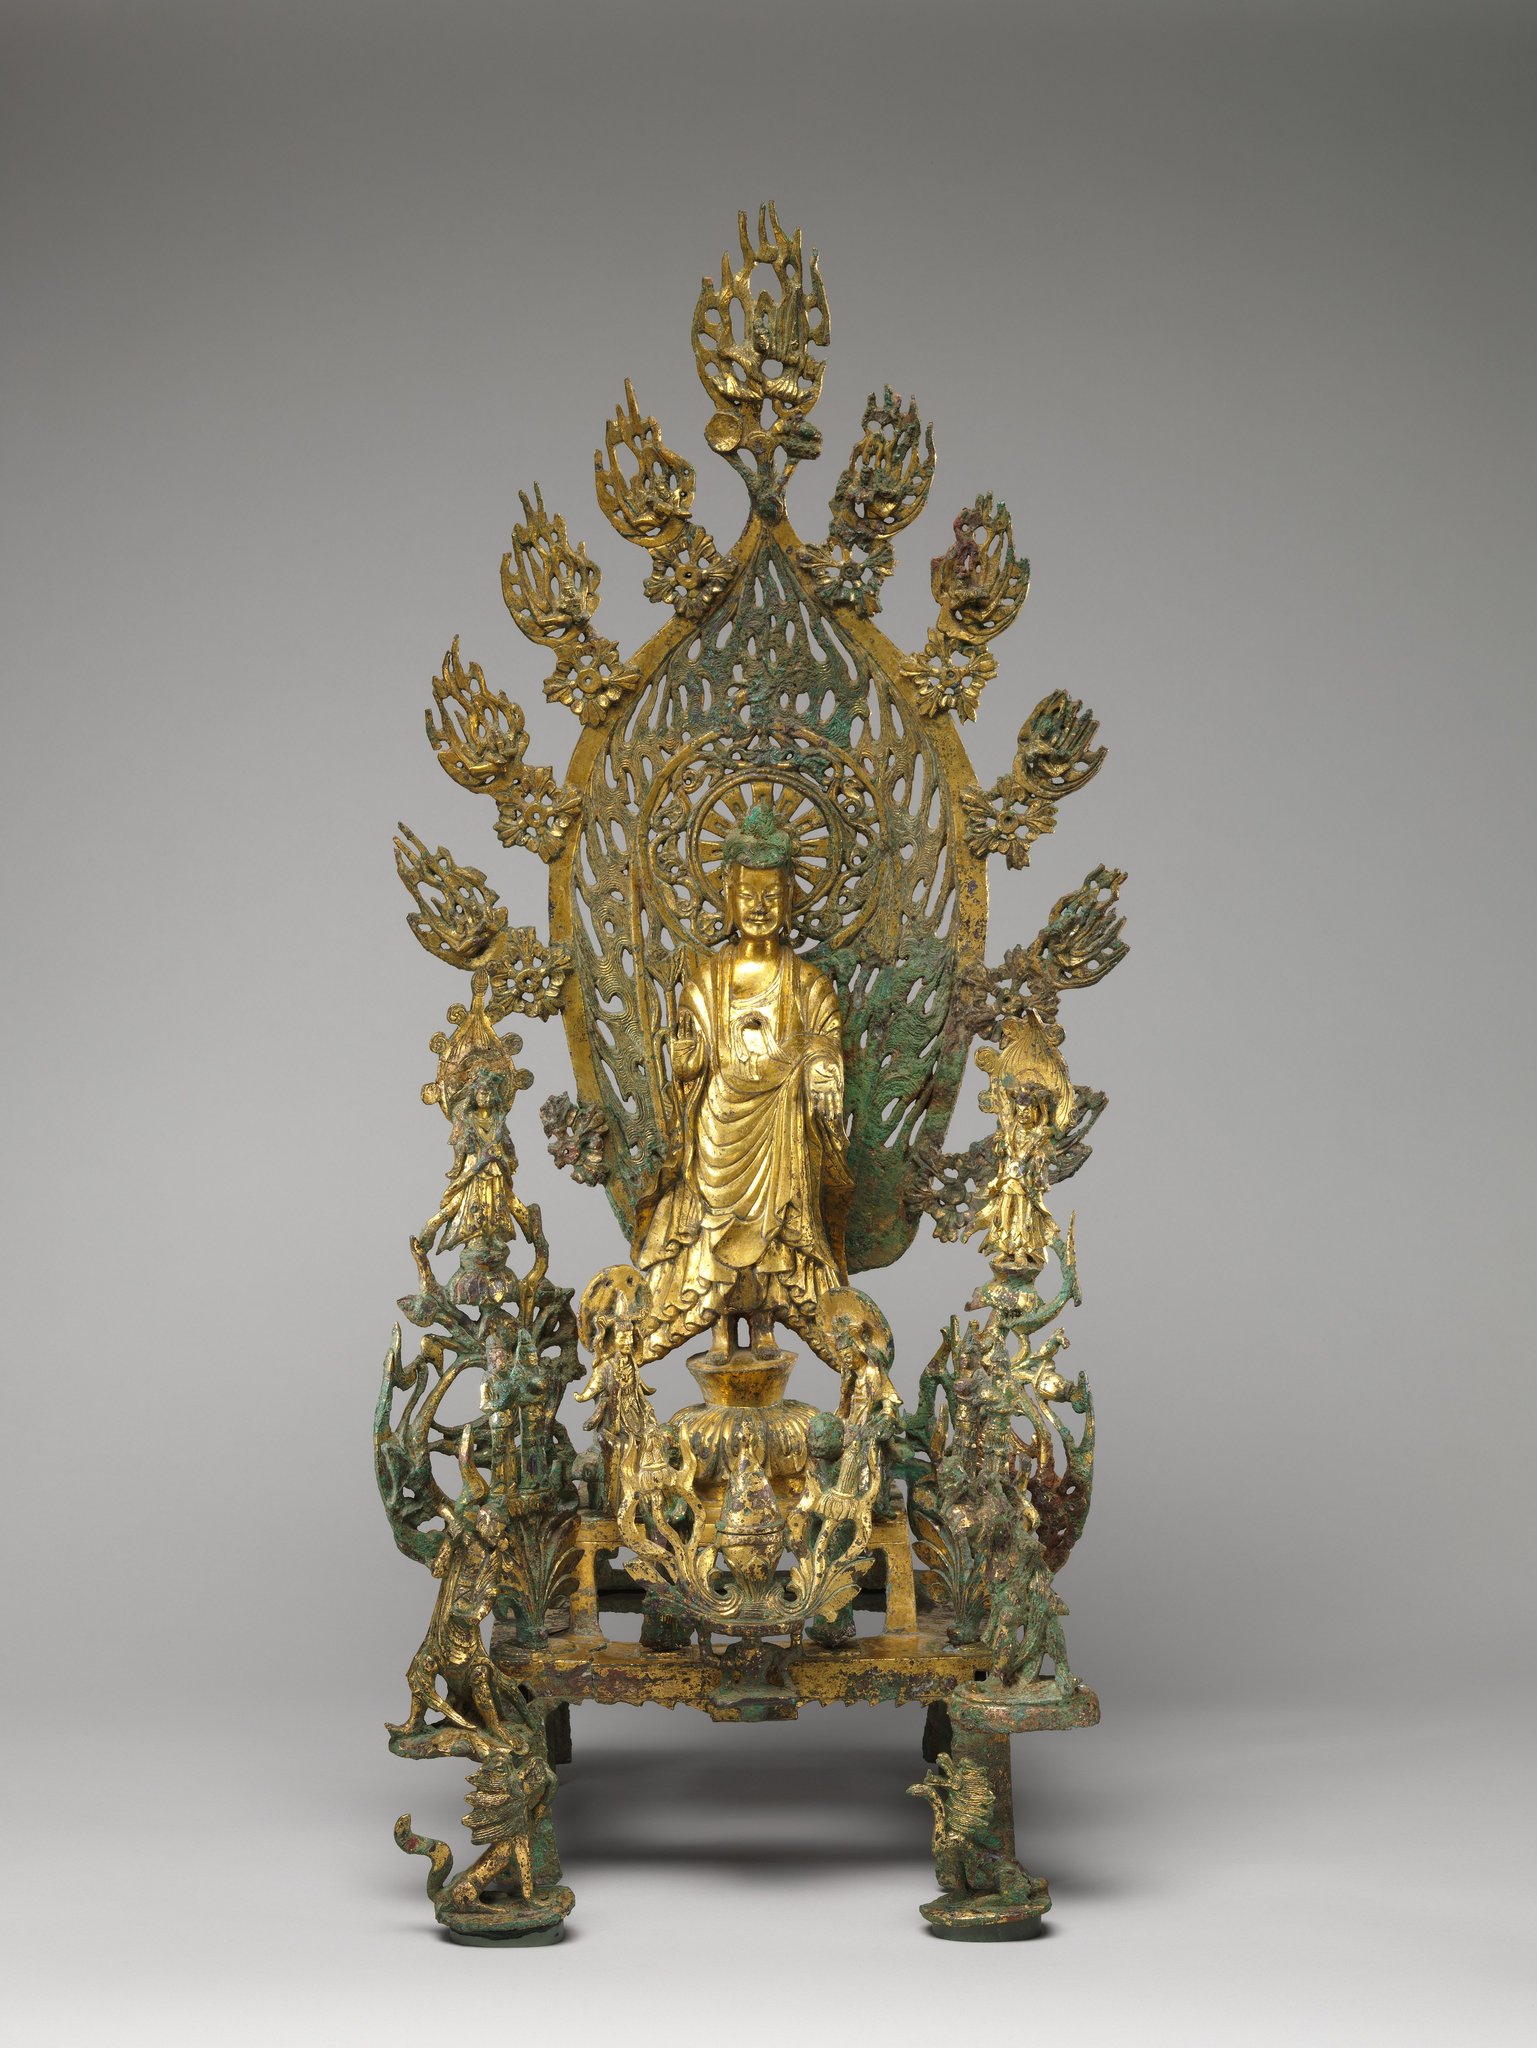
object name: altarpiece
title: Buddha Maitreya (Mile) Altarpiece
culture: chinese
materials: gilt bronze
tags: buddhism,buddha,maitreya